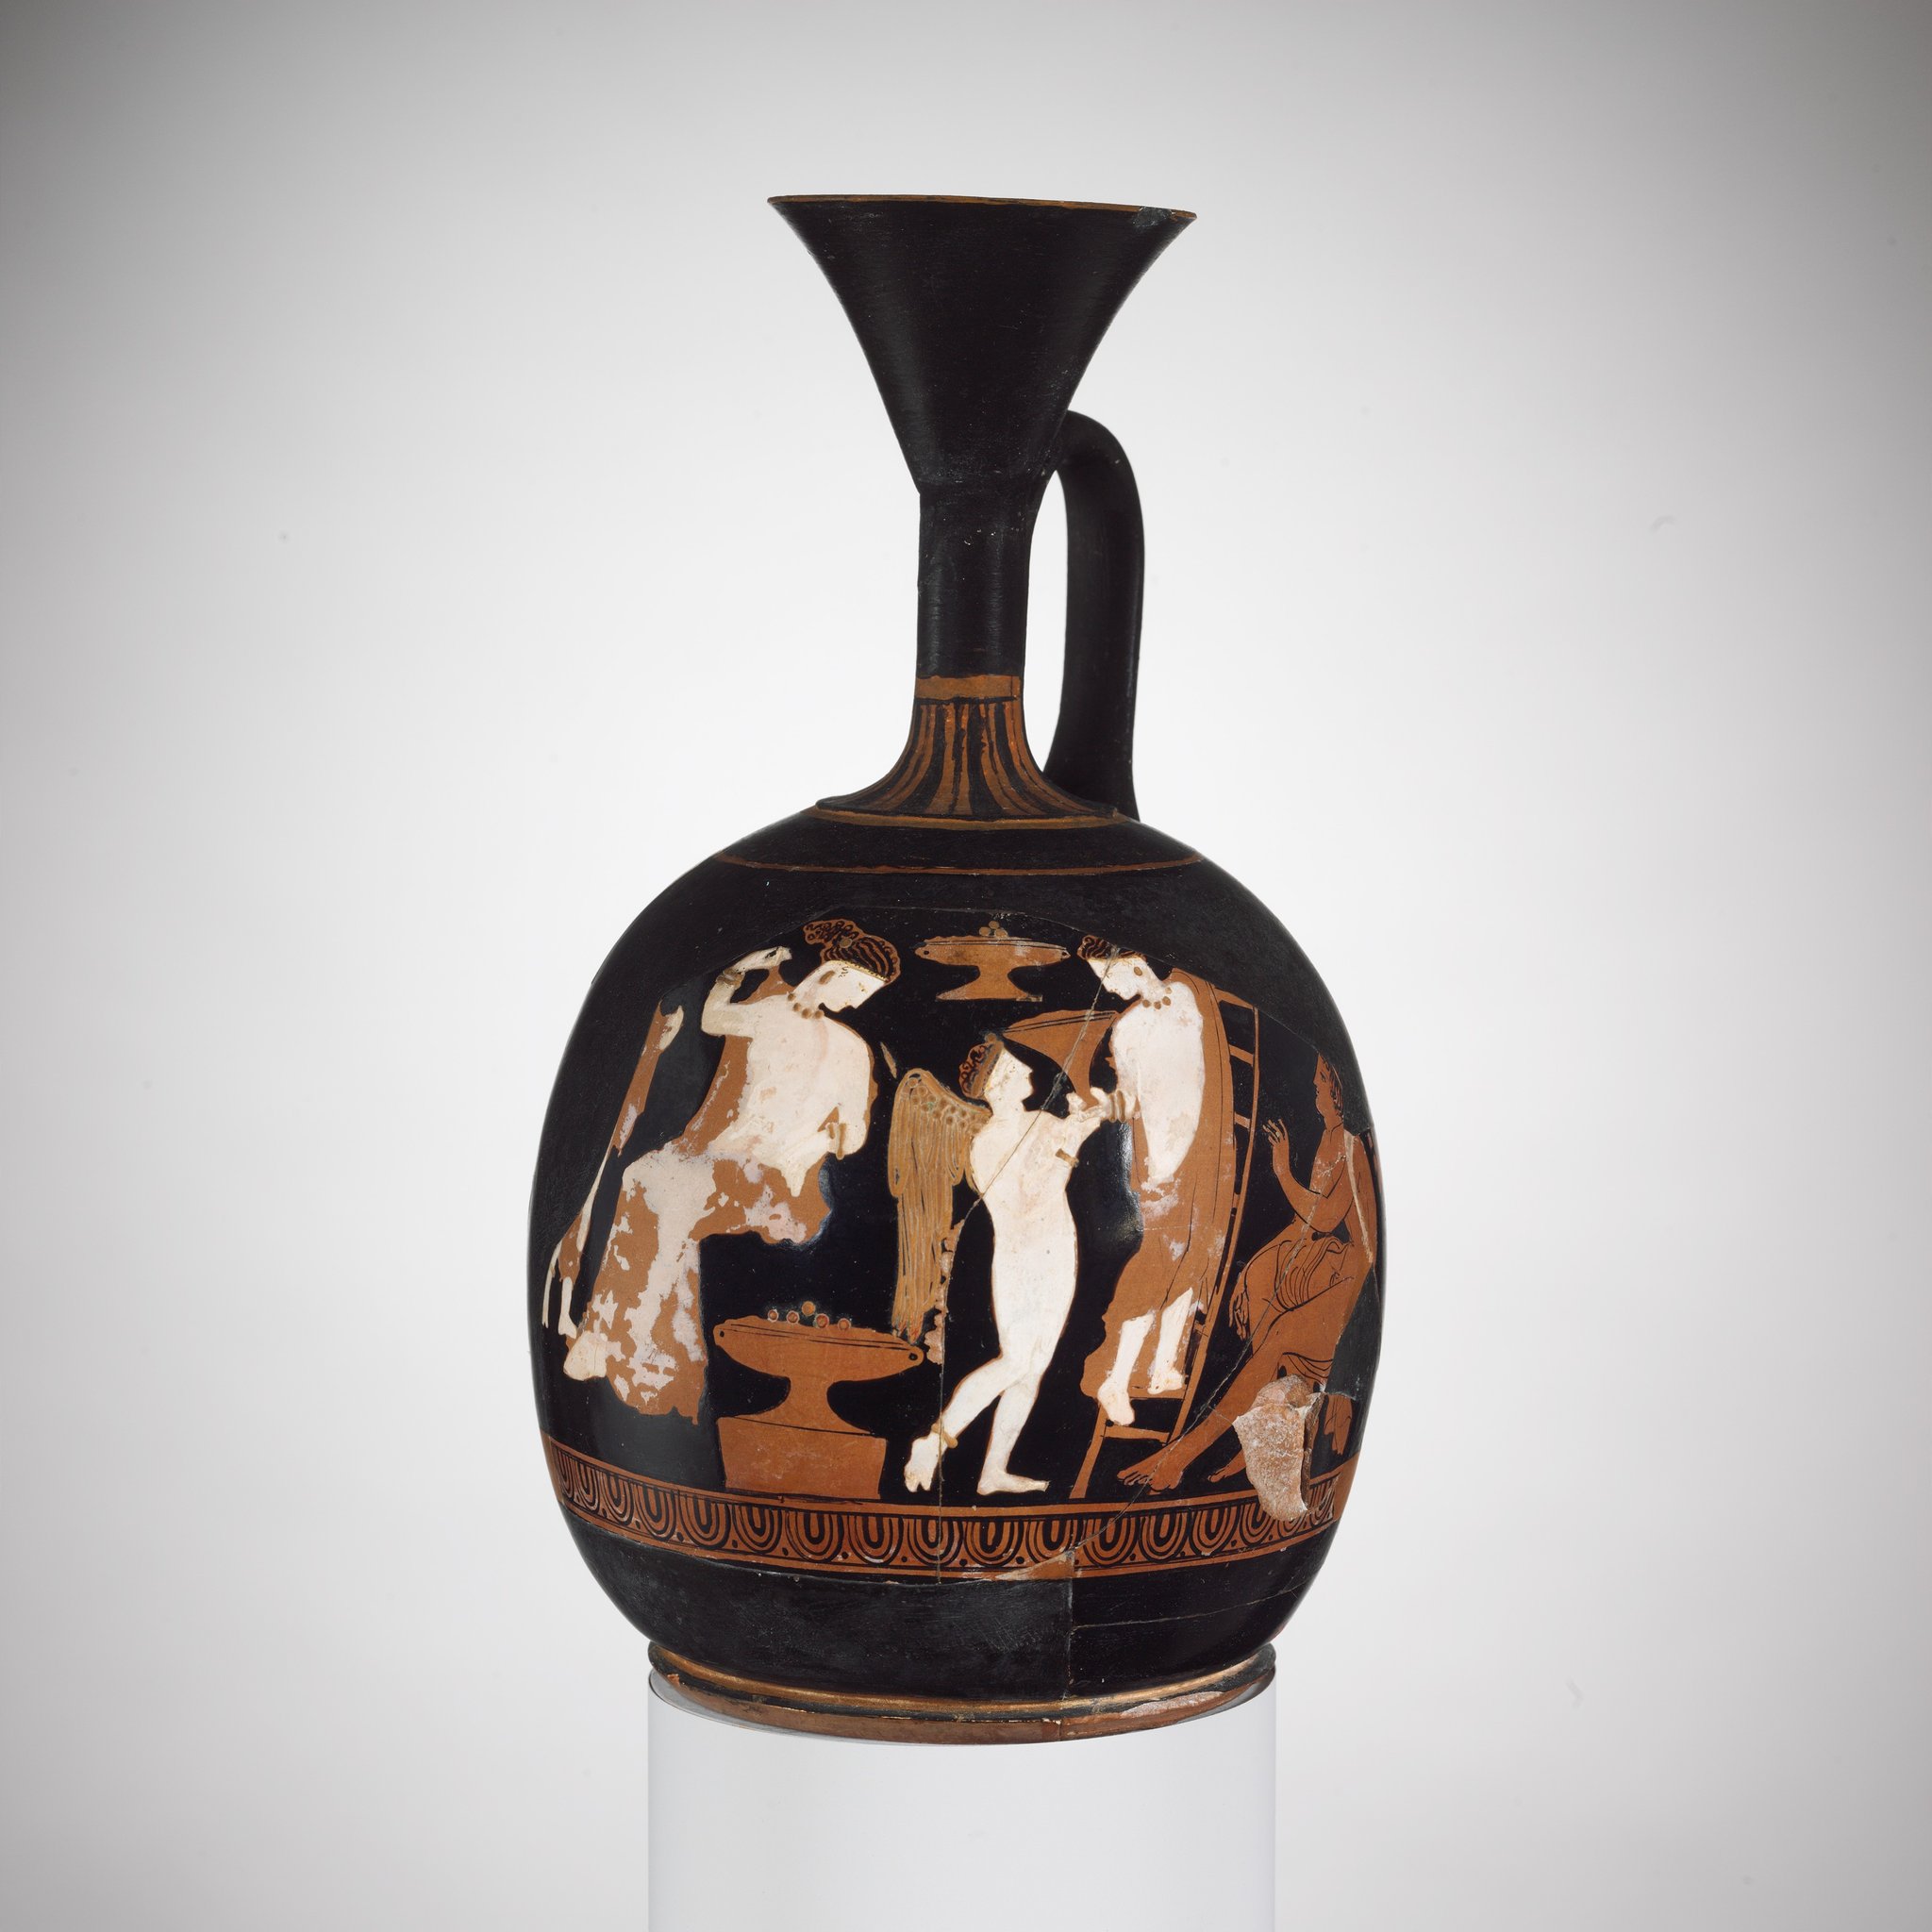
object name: squat lekythos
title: Terracotta squat lekythos (oil jar)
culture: greek, attic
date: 367-335 BCE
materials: terracotta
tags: men,women,adonis,eros